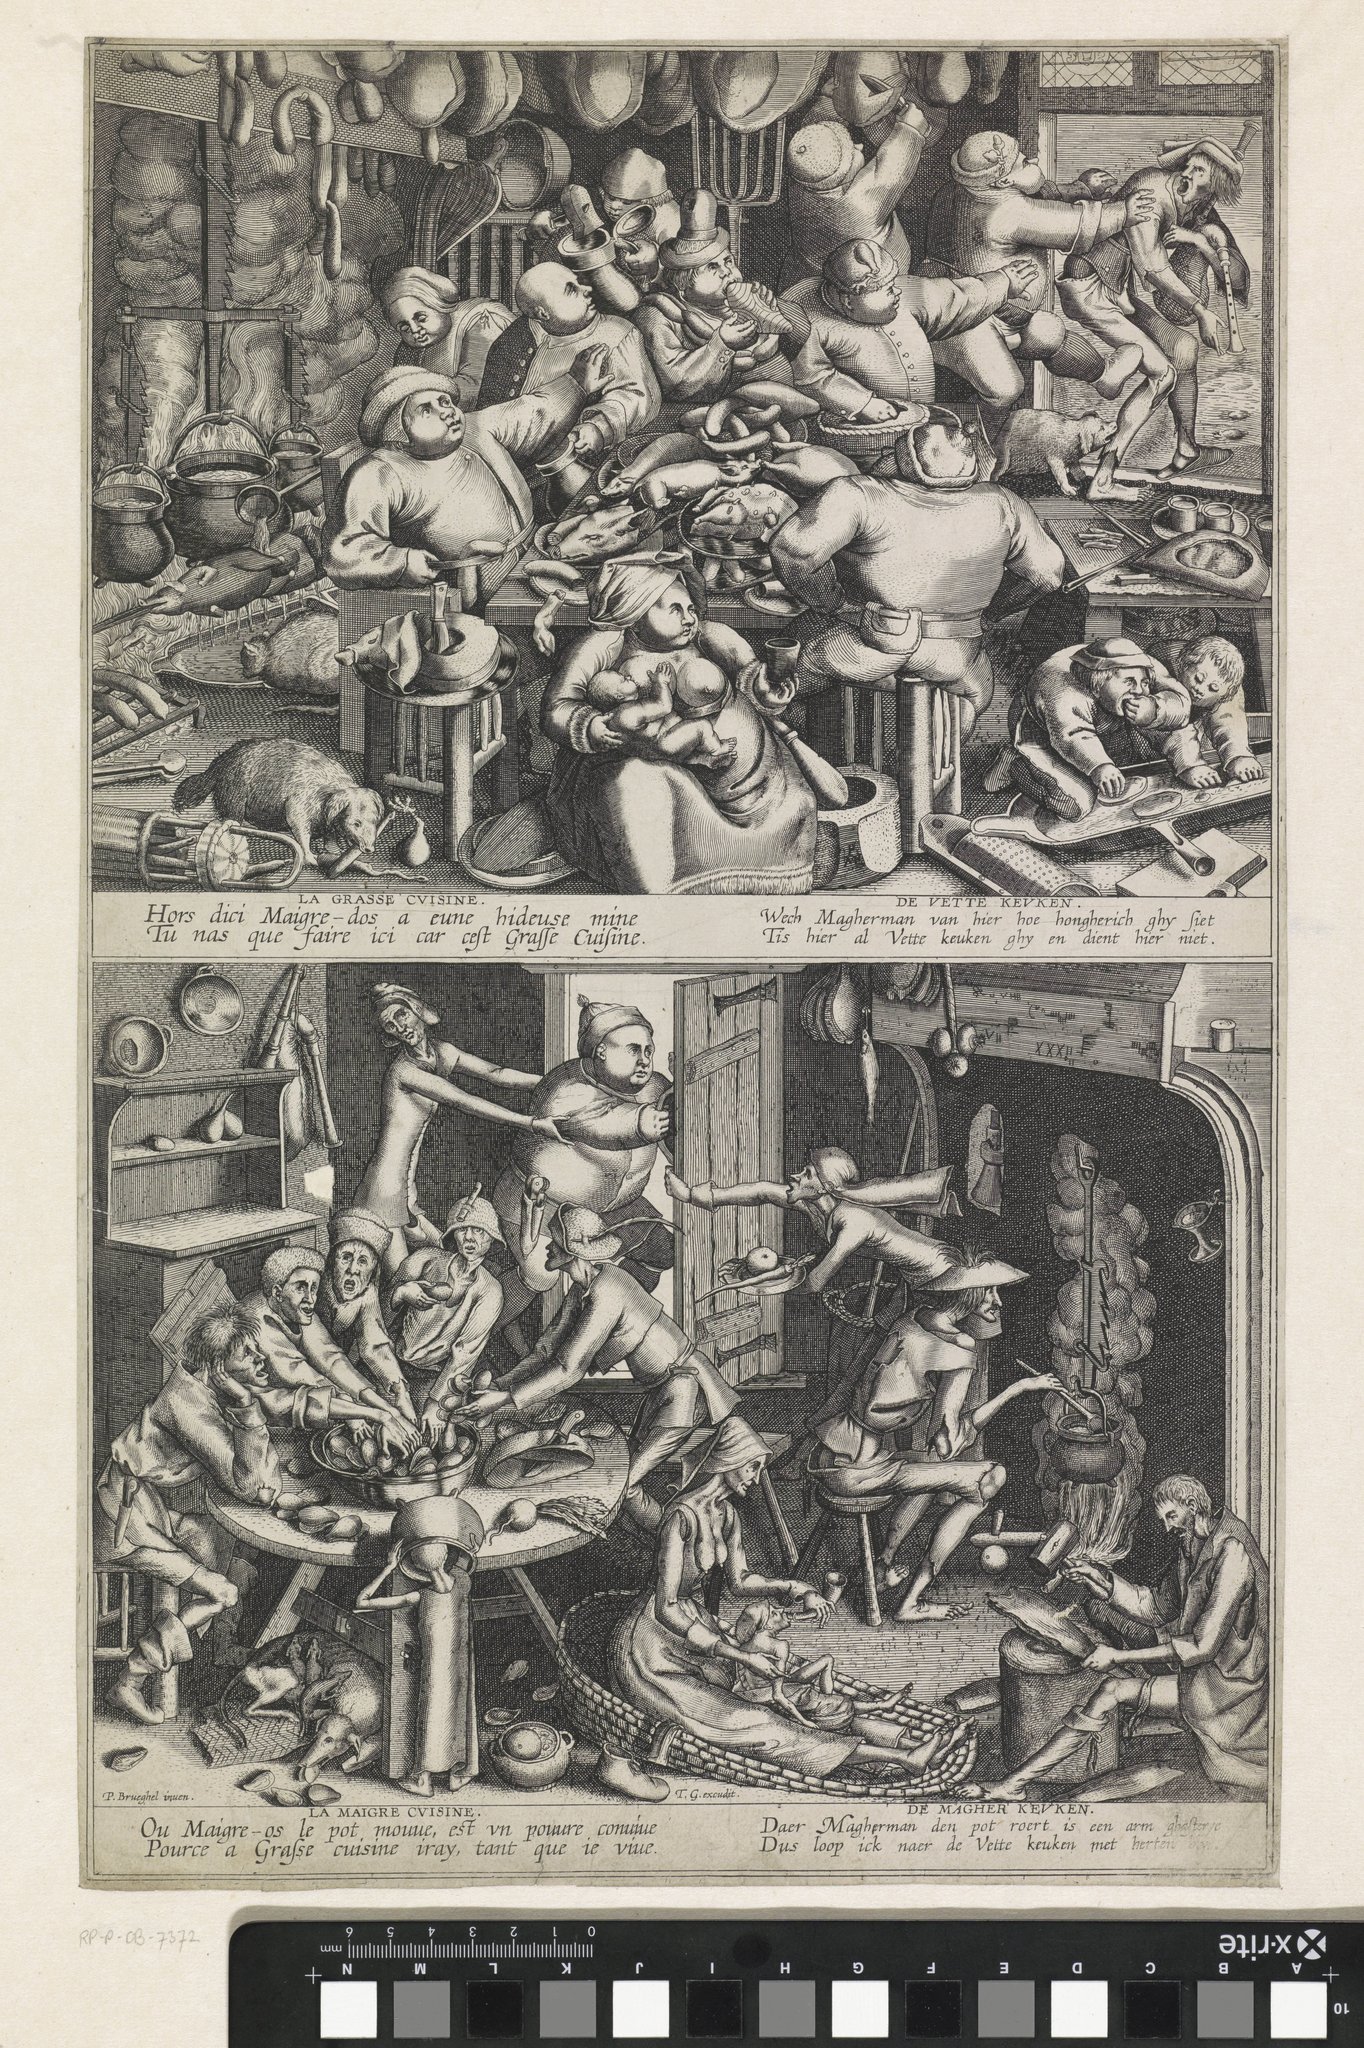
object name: print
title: Vette keuken en de magere keuken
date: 1595-1633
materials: paper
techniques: engraving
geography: antwerp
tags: nursing-chair (dutch: 'bakermat'), fat (human type), thin (human type), bagpipe, musette, kitchen-interior, beggar, poor kitchen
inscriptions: collector's mark: Lugt 2228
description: Twee voorstellingen op een blad. Boven: Keukeninterieur waarin een groep van dikke mensen zich aan allerlei eten en drinken te goed doet. Links wordt in de haard gekookt en gebraden. Op de voorgrond rechts twee met eten spelende kinderen en in het midden een drinkende vrouw die een kind de borst geeft. Op de achtergrond wordt een armoedige magere man met doedelzak de deur uit gejaagd. Onder de voorstelling een tweeregelig vers in het Frans en in het Nederlands. Onder: Keukeninterieur met magere mensen die aan een tafel mosselen eten. Een man roert in een ketel op het vuur en vooraan geeft een vrouw een kind uit een drinkhoorn te drinken. Boven probeert een dikke man de magere keuken te ontvluchten, terwijl twee magere mensen hem proberen binnen te halen. Onder de voorstelling een tweereglig vers in het Frans en in het Nederlands.